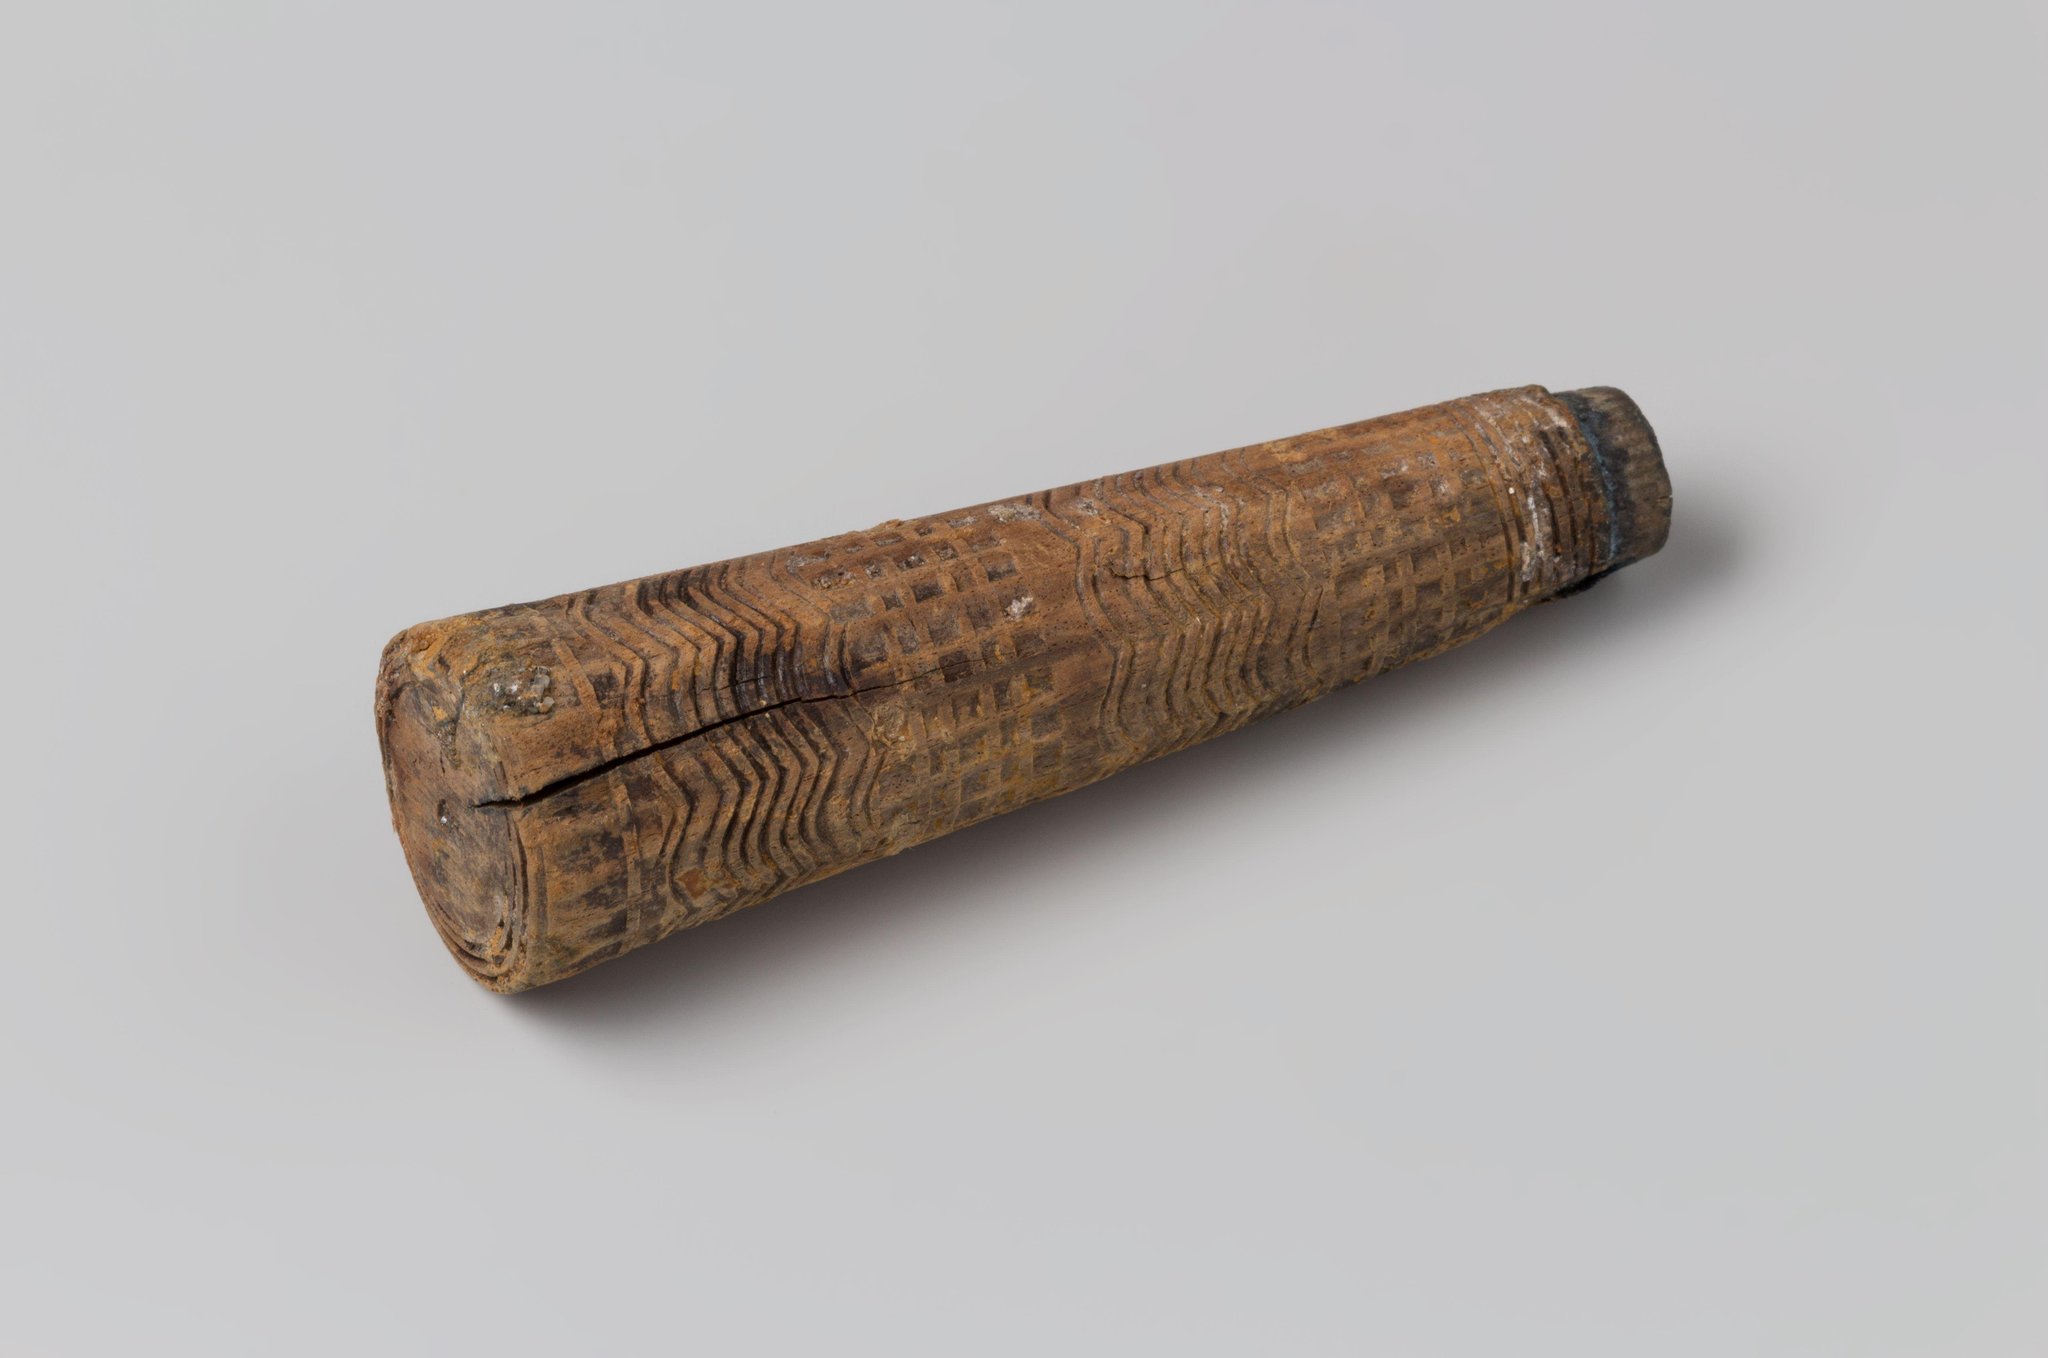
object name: knife handle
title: Messenheft uit het wrak van de Oost-Indiëvaarder Hollandia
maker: Anonymous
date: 1700-1743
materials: wood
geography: netherlands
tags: verenigde oostindische compagnie, hollandia (schip), annet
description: Knife, handle, cylindrical: tapering; id. NG 1979-403H, ferrules, id. NG 1980-27H426.